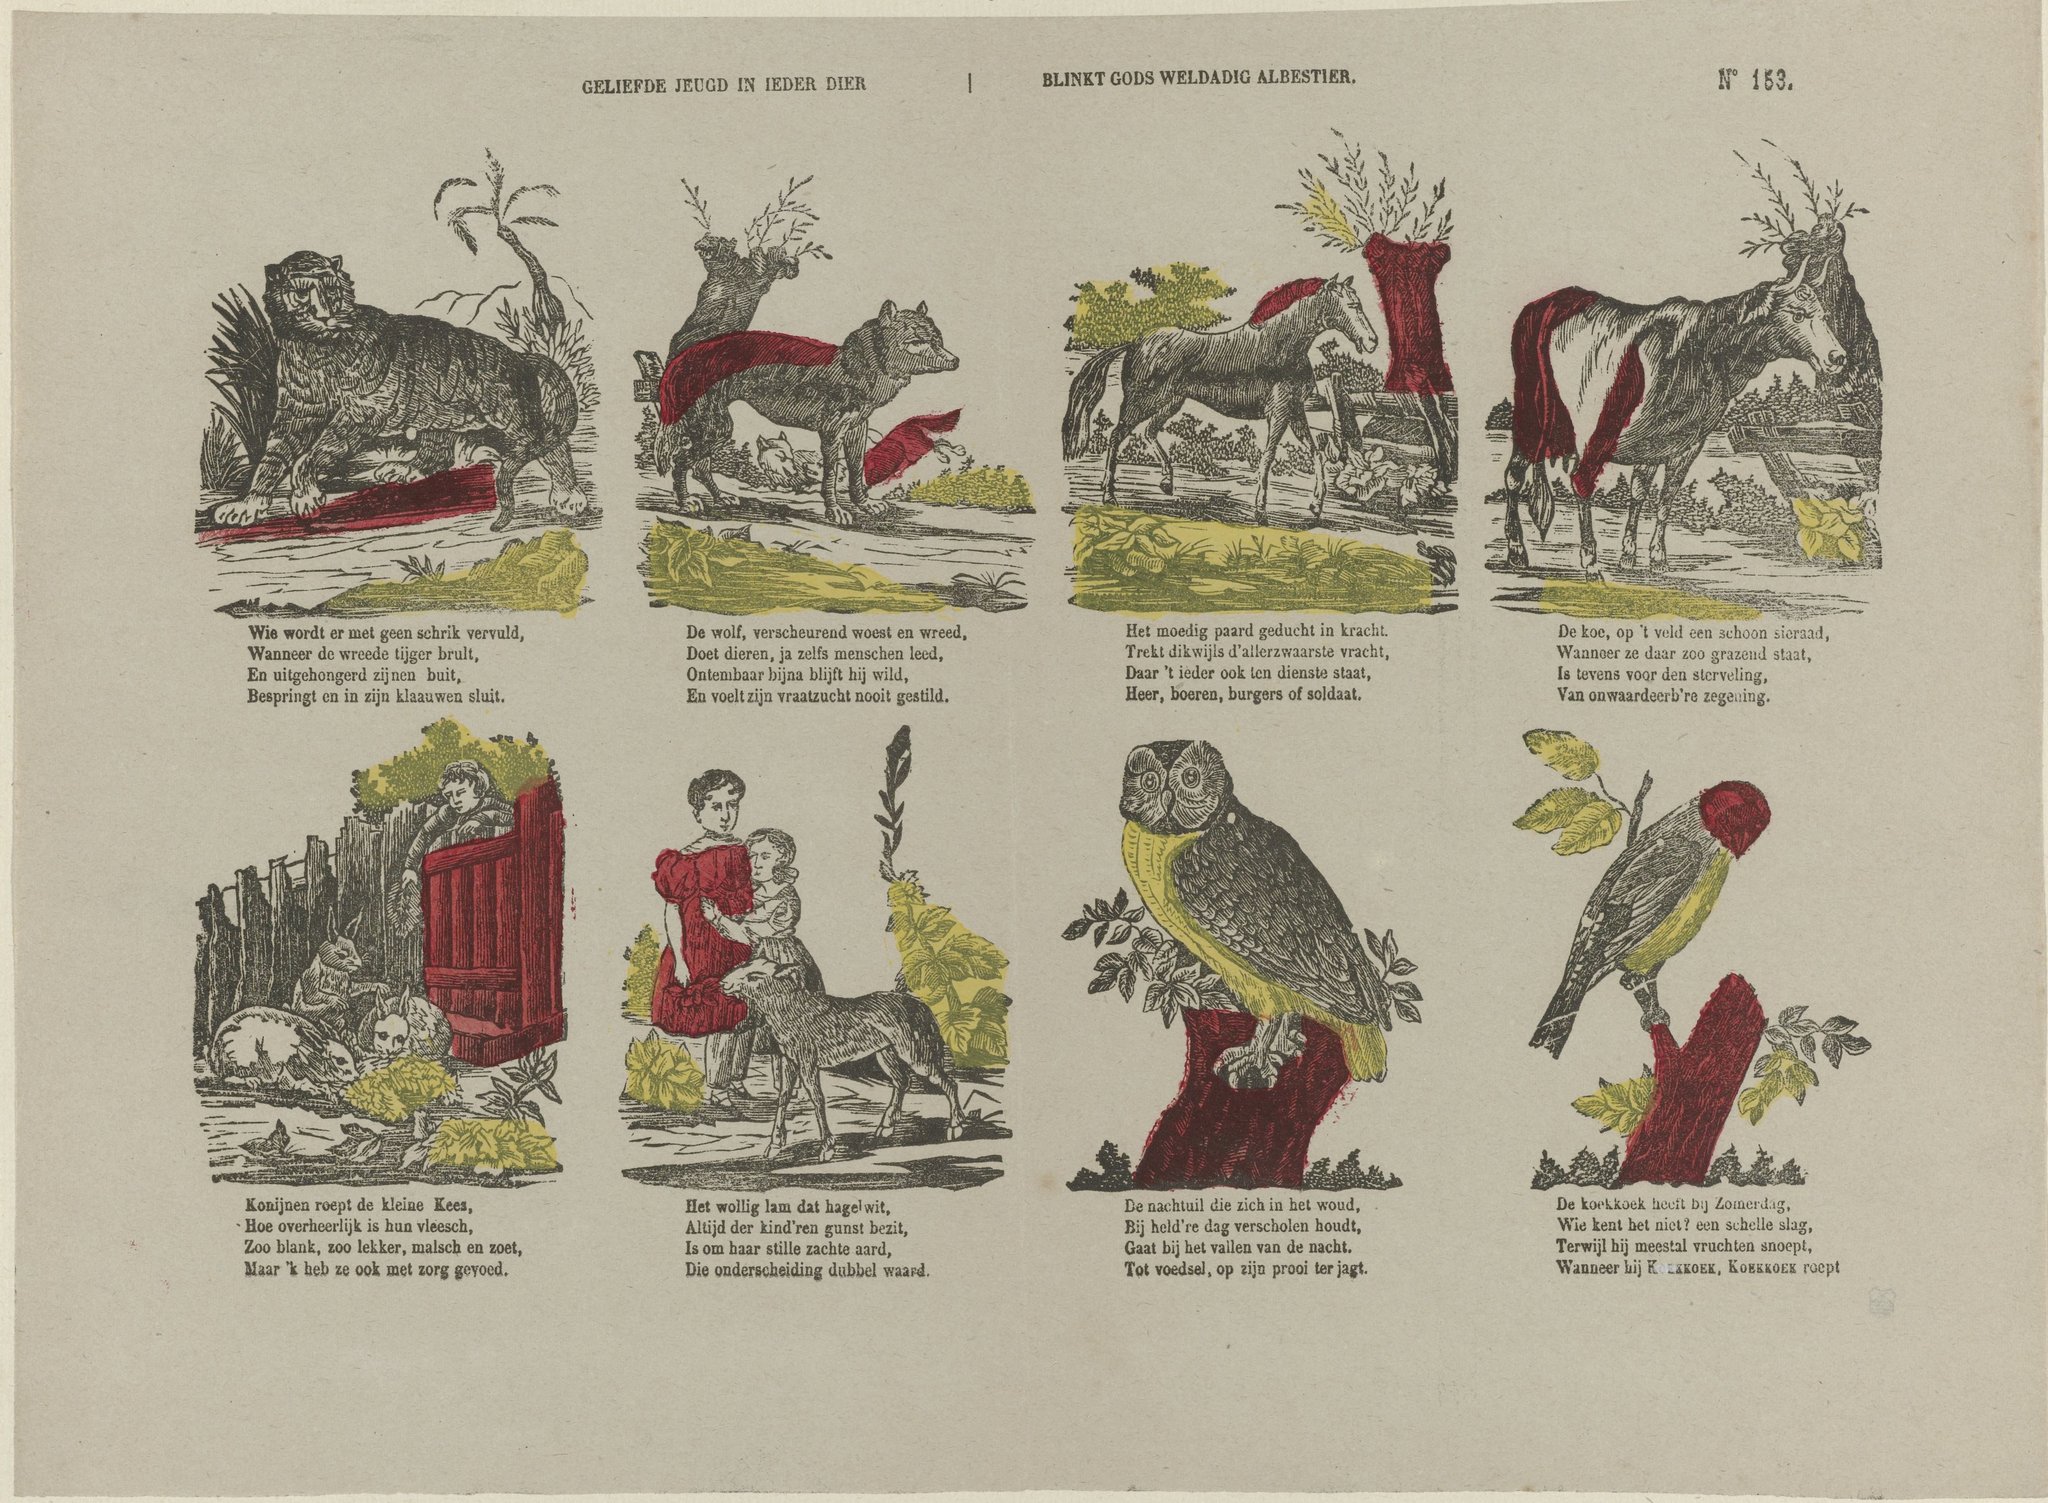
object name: popular print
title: Geliefde jeugd in ieder dier / Blinkt Gods weldadig albestier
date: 1827-1894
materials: paper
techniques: colour, letterpress printing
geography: schaarbeek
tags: beasts of prey, predatory animals: tiger, cow, animals, birds, owls, horse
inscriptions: collector's mark: Lugt 2760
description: Blad met 8 voorstellingen van dieren, zoals een tijger, een wolf, een paard en een uil. Onder elke voorstelling een vierregelig vers. Genummerd rechtsboven: No 153.